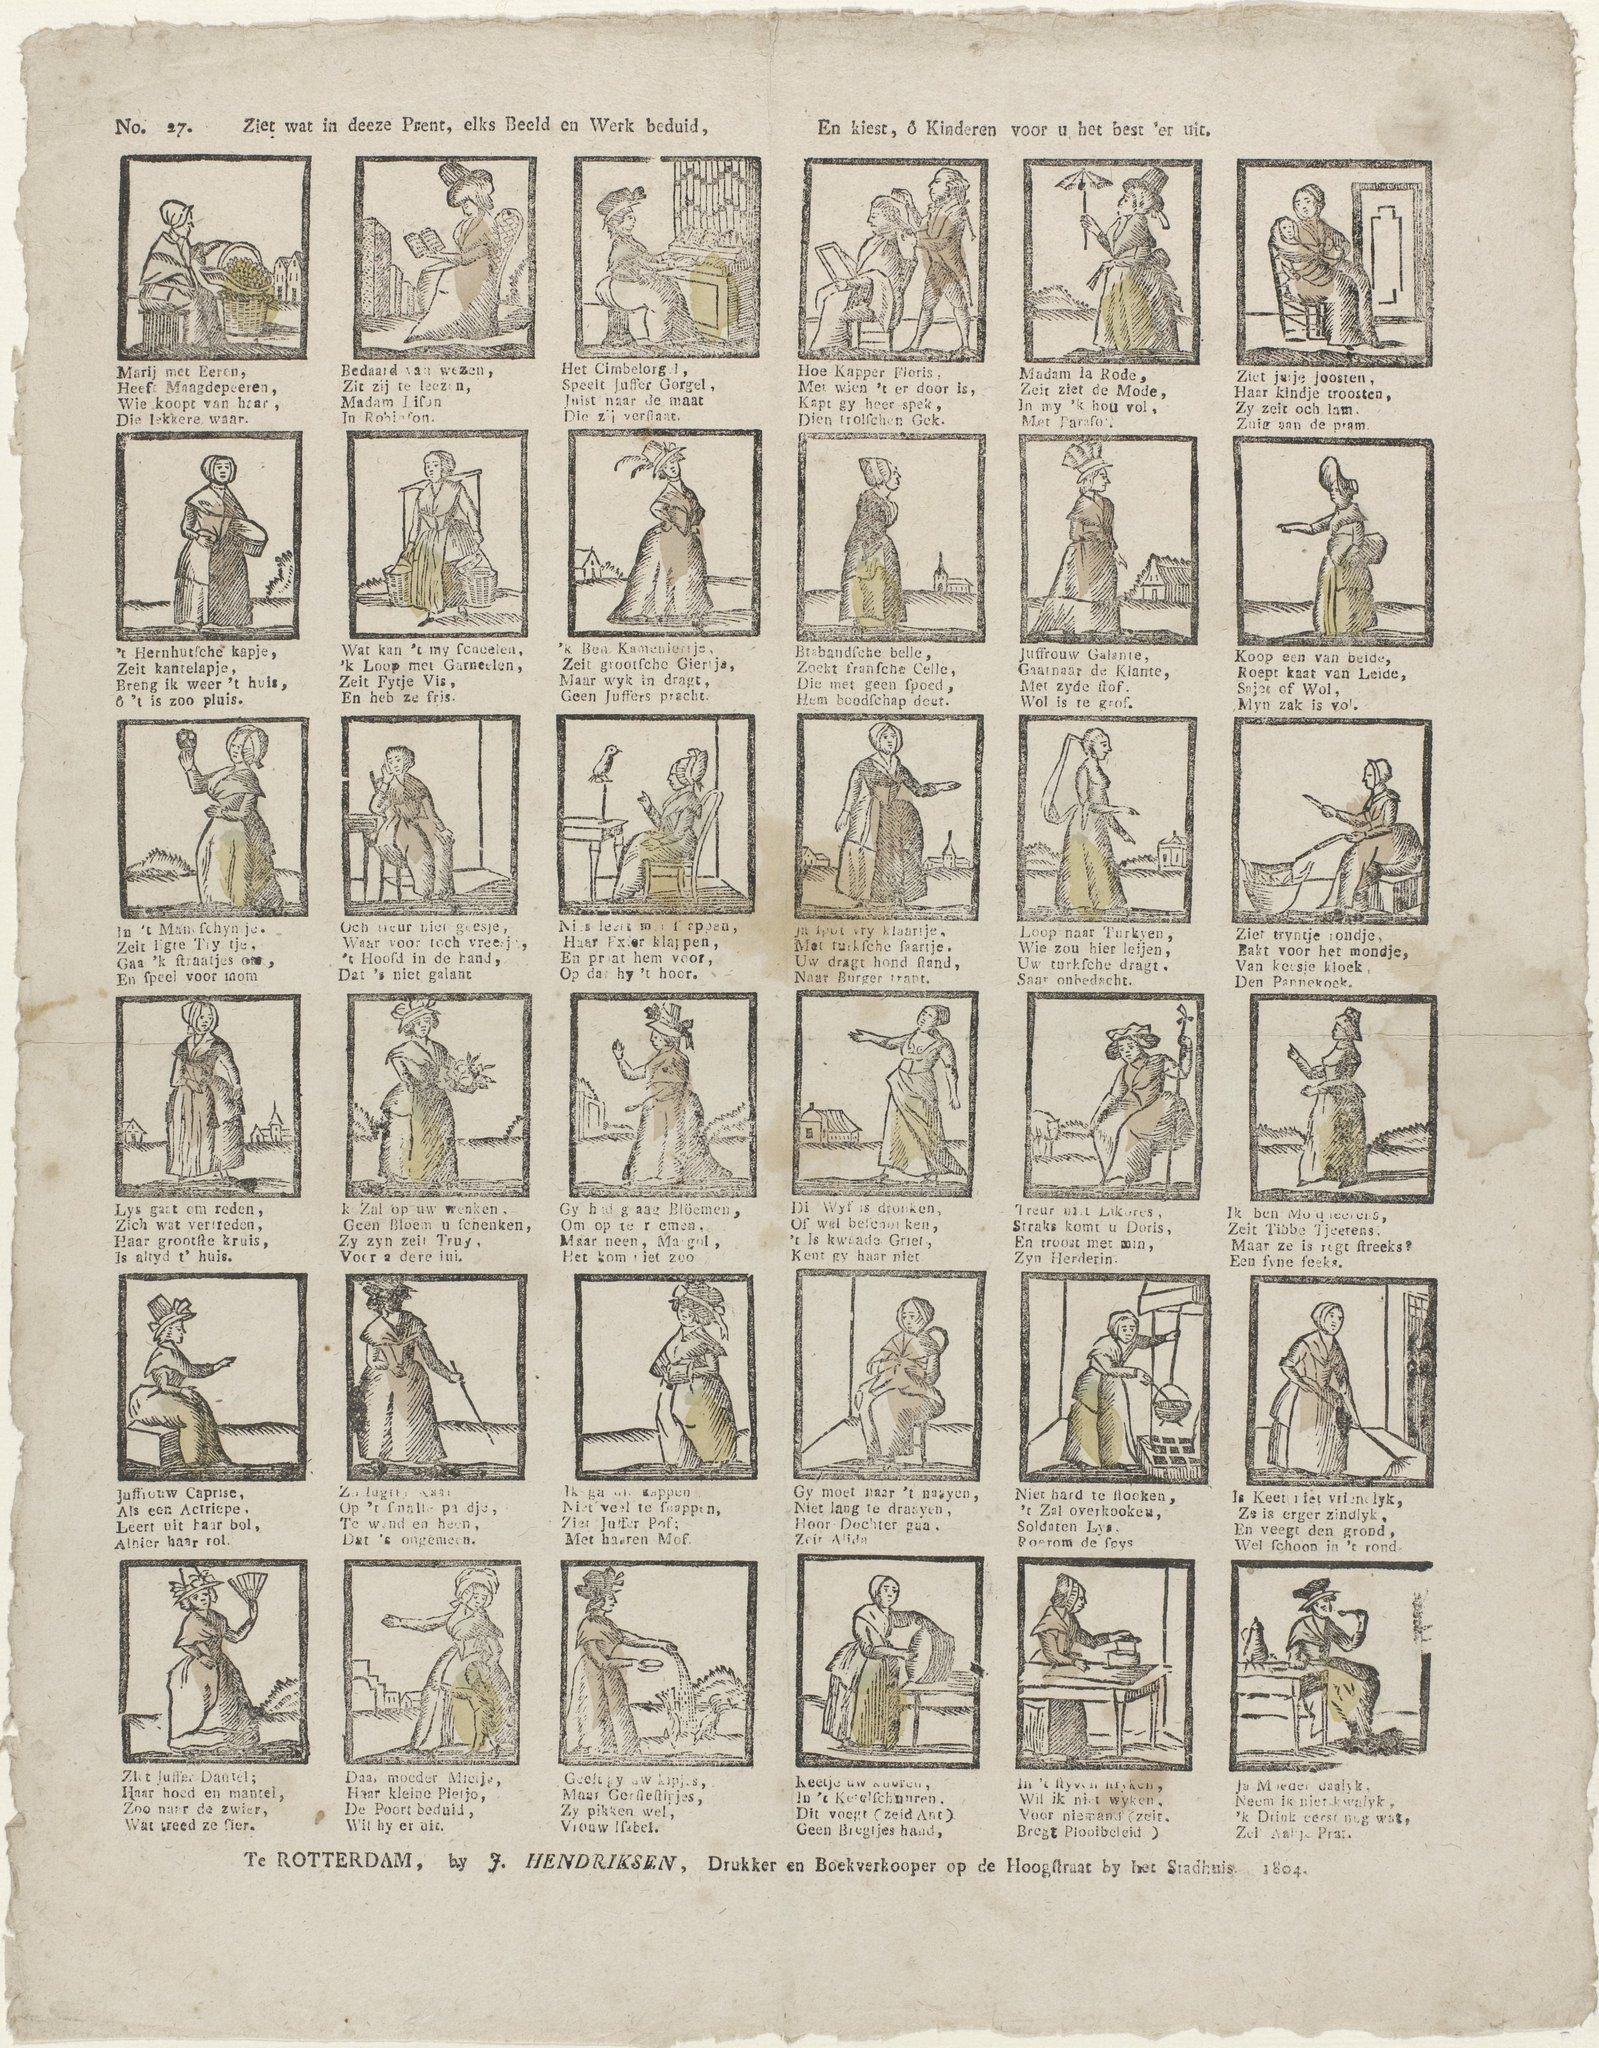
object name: print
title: Ziet wat in deeze prent, elk beeld en werk beduid, / En kiest, ô kinderen voor u het best ér uit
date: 1804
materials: paper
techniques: colour, letterpress printing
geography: rotterdam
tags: musician at work, amusement, cooking food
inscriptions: collector's mark: Lugt 2760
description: Blad met 36 voorstellingen van vrouwelijke beroepen en bezigheden, zoals orgel spelen, kippen voeren en koken. Onder elke afbeelding een vierregelig vers. Genummerd linksboven: No. 27.